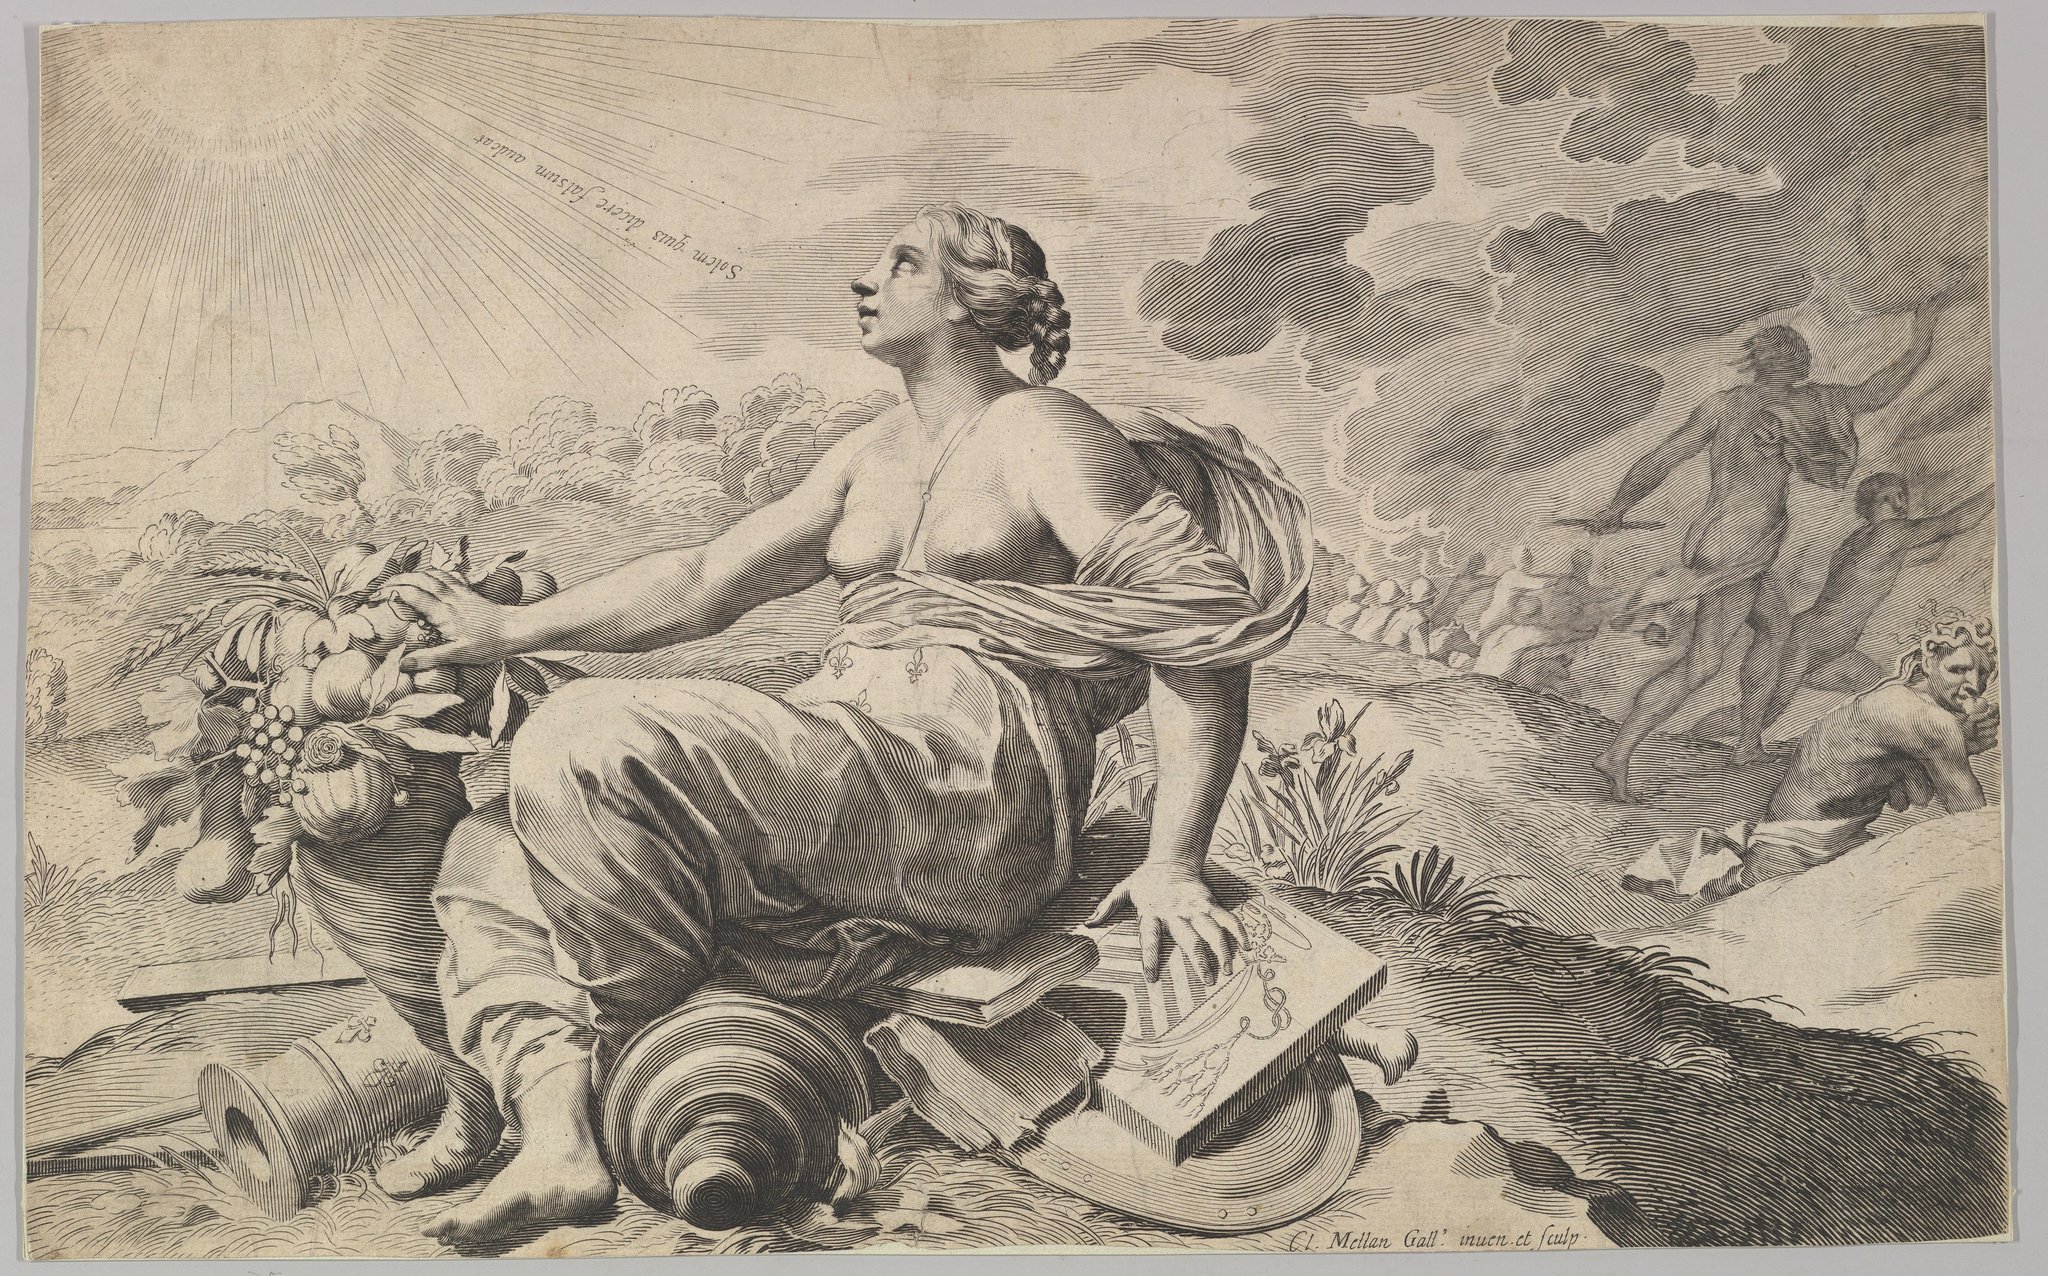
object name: print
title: Allegory of France with the Arms of Richelieu (Allégorie sur la Paix)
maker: claude mellan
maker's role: artist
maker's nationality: french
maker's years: 1598-1688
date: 1620-1642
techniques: engraving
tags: men,women,female nudes,cornucopia,allegory